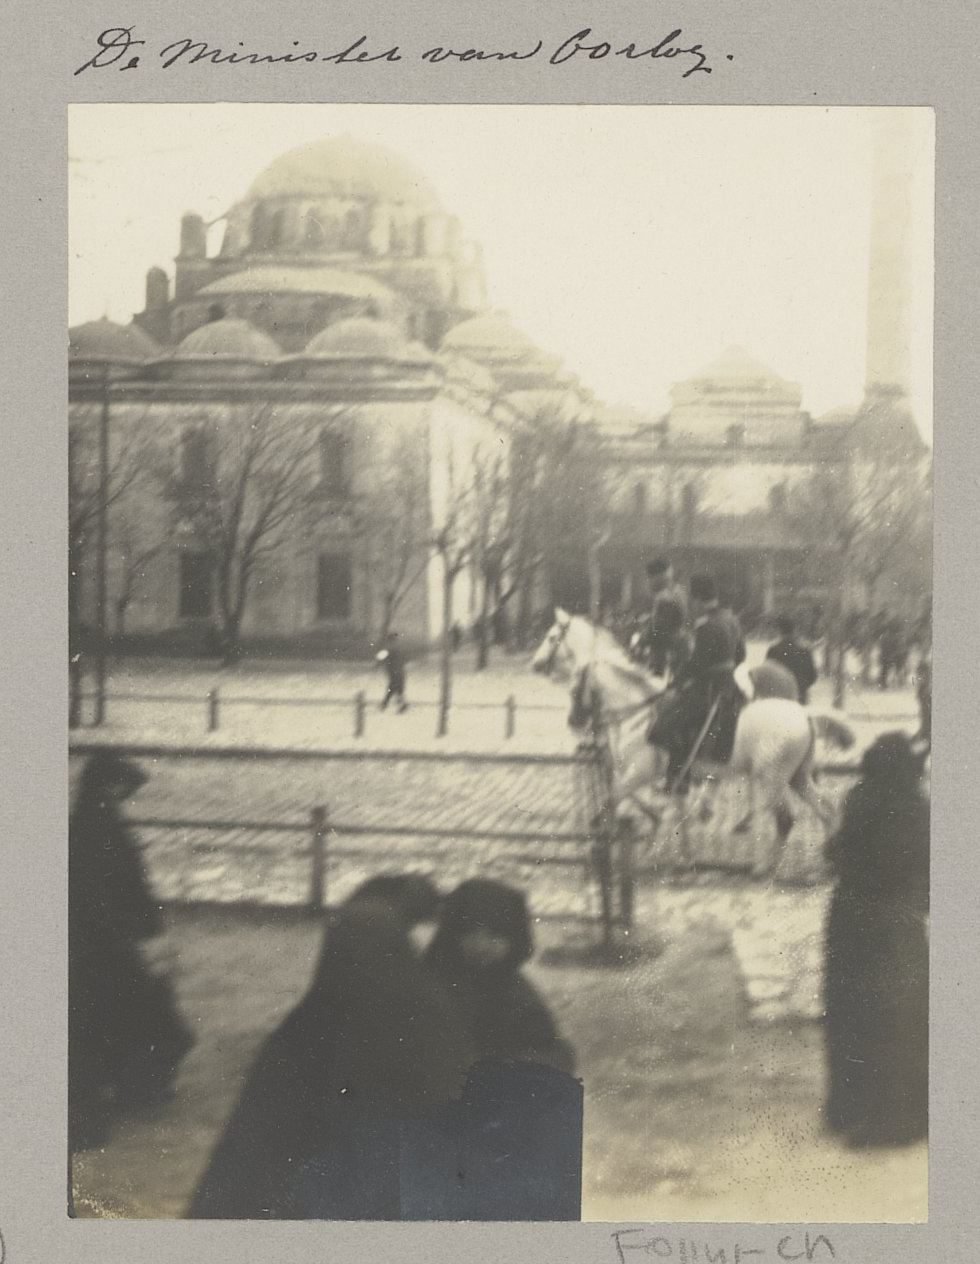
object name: photograph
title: Minister van Oorlog van het Ottomaanse Rijk te paard te midden van passanten op straat in Istanbul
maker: Anonymous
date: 1910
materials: photographic support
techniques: gelatin silver print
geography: istanbul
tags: riding a horse, ass, or mule; rider, horseman, military parade, pageant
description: Onderdeel van Fotoalbum van een reis door Zuid-Europa en het Midden-Oosten.